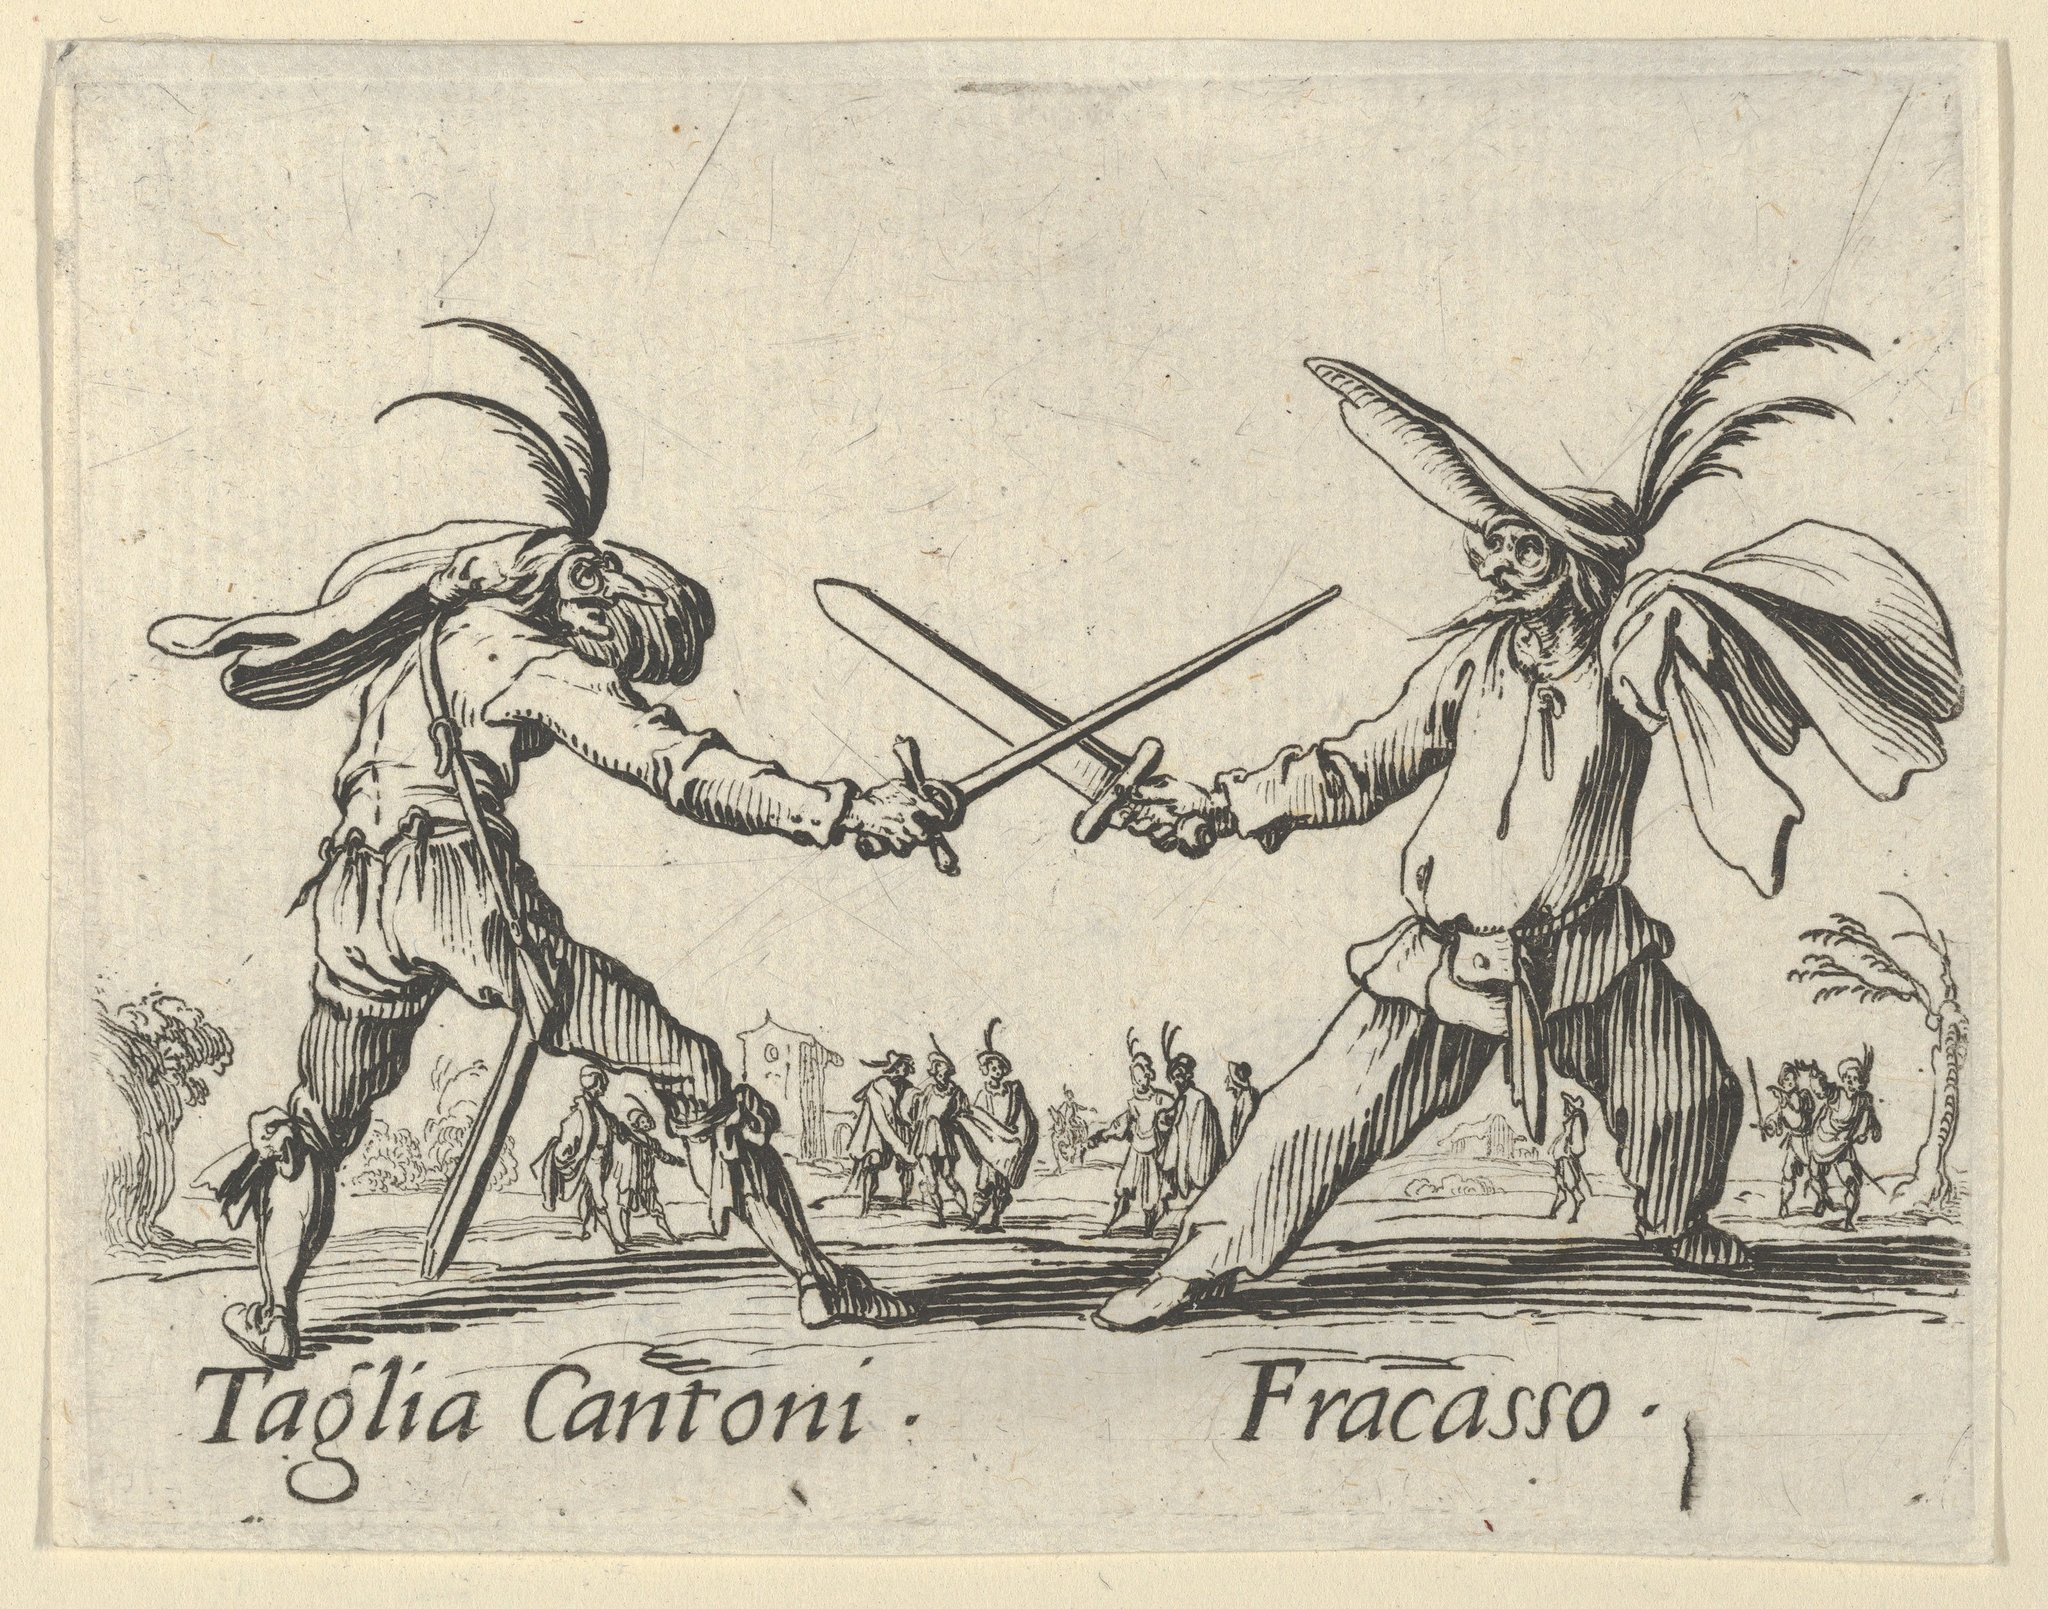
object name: print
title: Taglia Cantoni - Fracasso, from "Balli di Sfessania" (Dance of Sfessania)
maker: jacques callot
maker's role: artist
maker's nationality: french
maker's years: 1592-1635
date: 1622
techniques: etching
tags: swords,men,entertainment